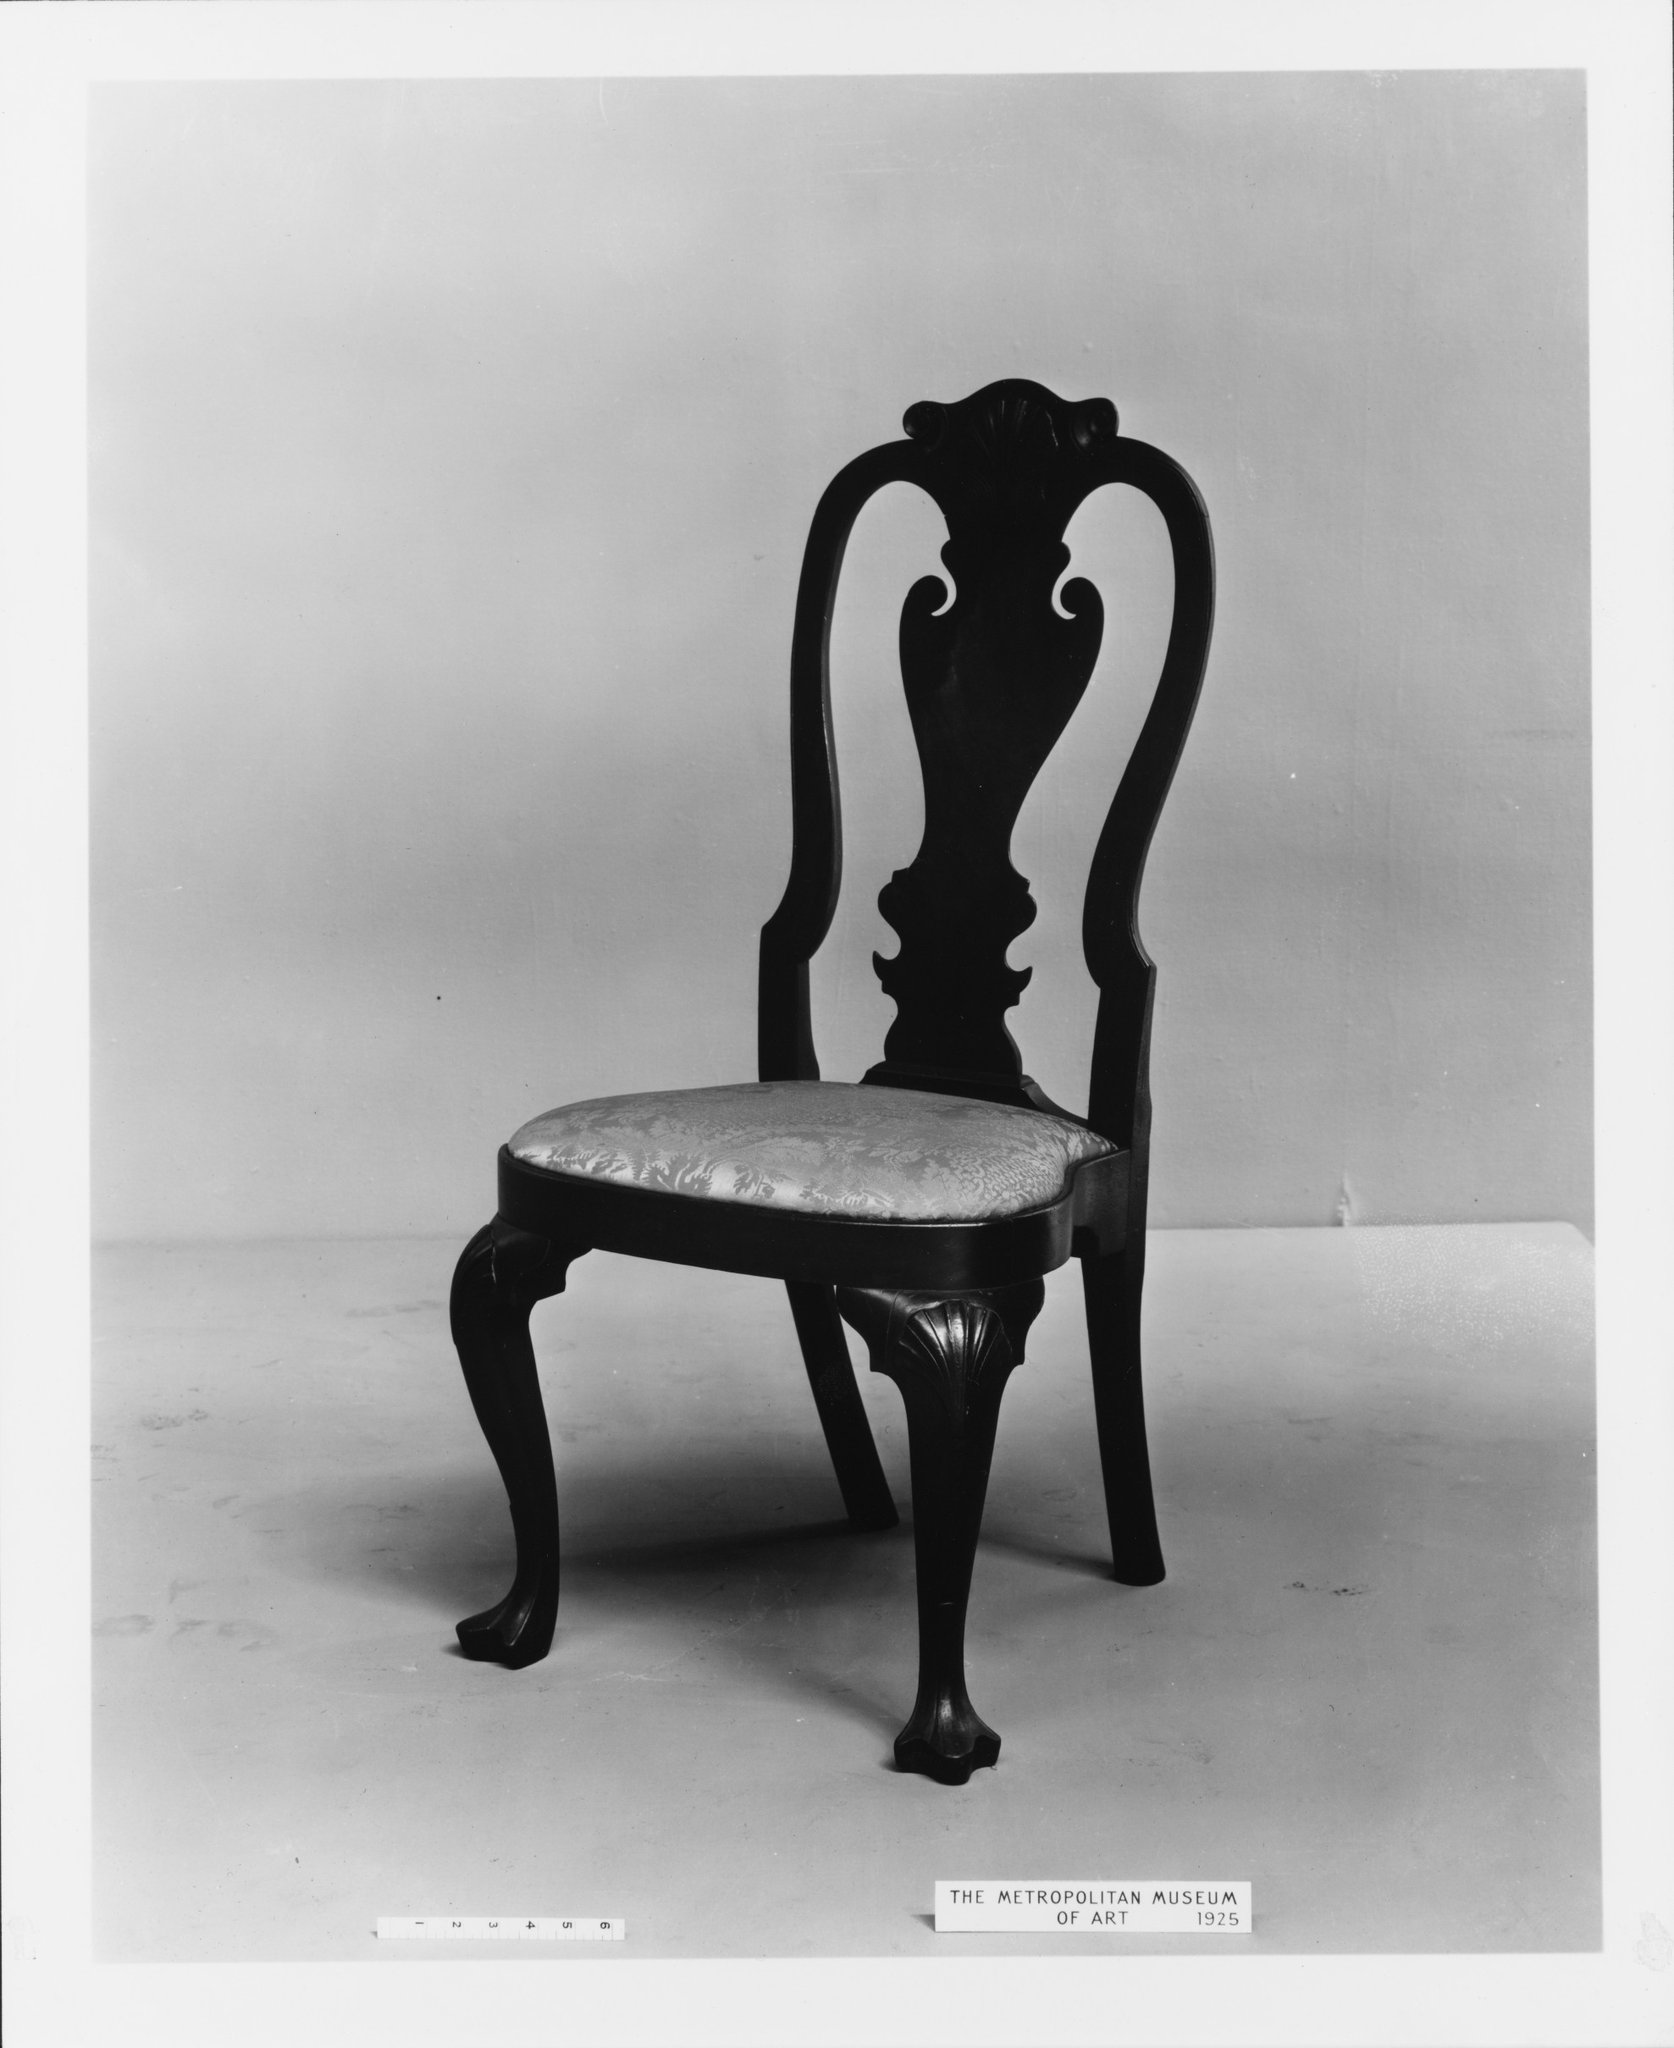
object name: side chair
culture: american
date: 1740-1760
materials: wood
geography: united states